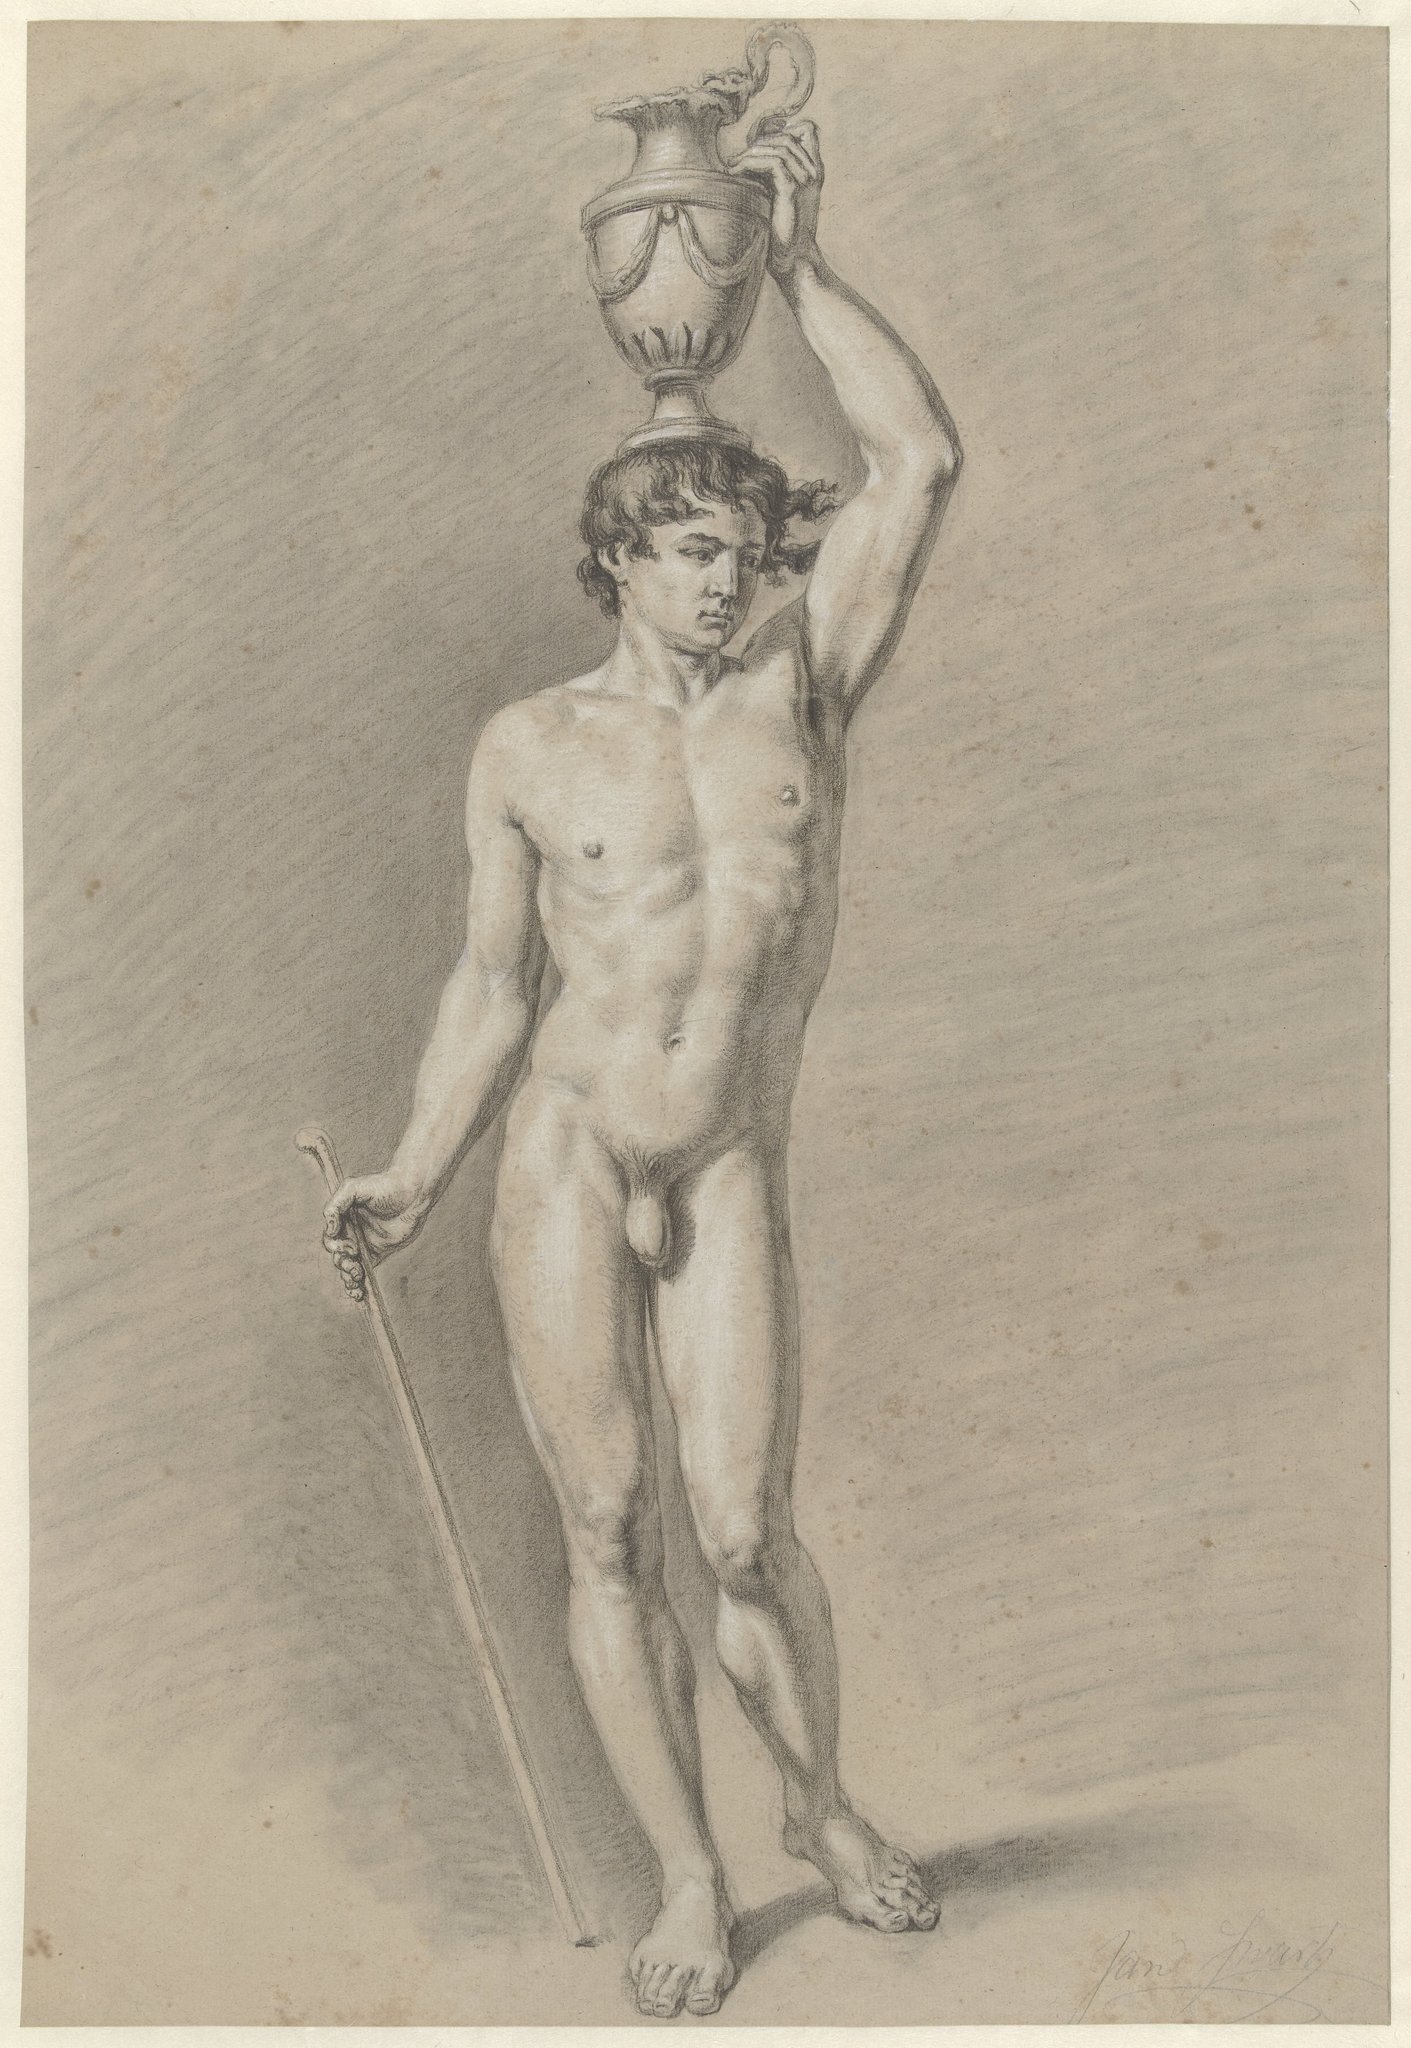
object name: drawing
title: Staand mannelijk naakt met een vaas op het hoofd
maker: jan swart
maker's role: draughtsman, print maker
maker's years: 1754-1794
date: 1779-1794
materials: chalk, paper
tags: standing figure